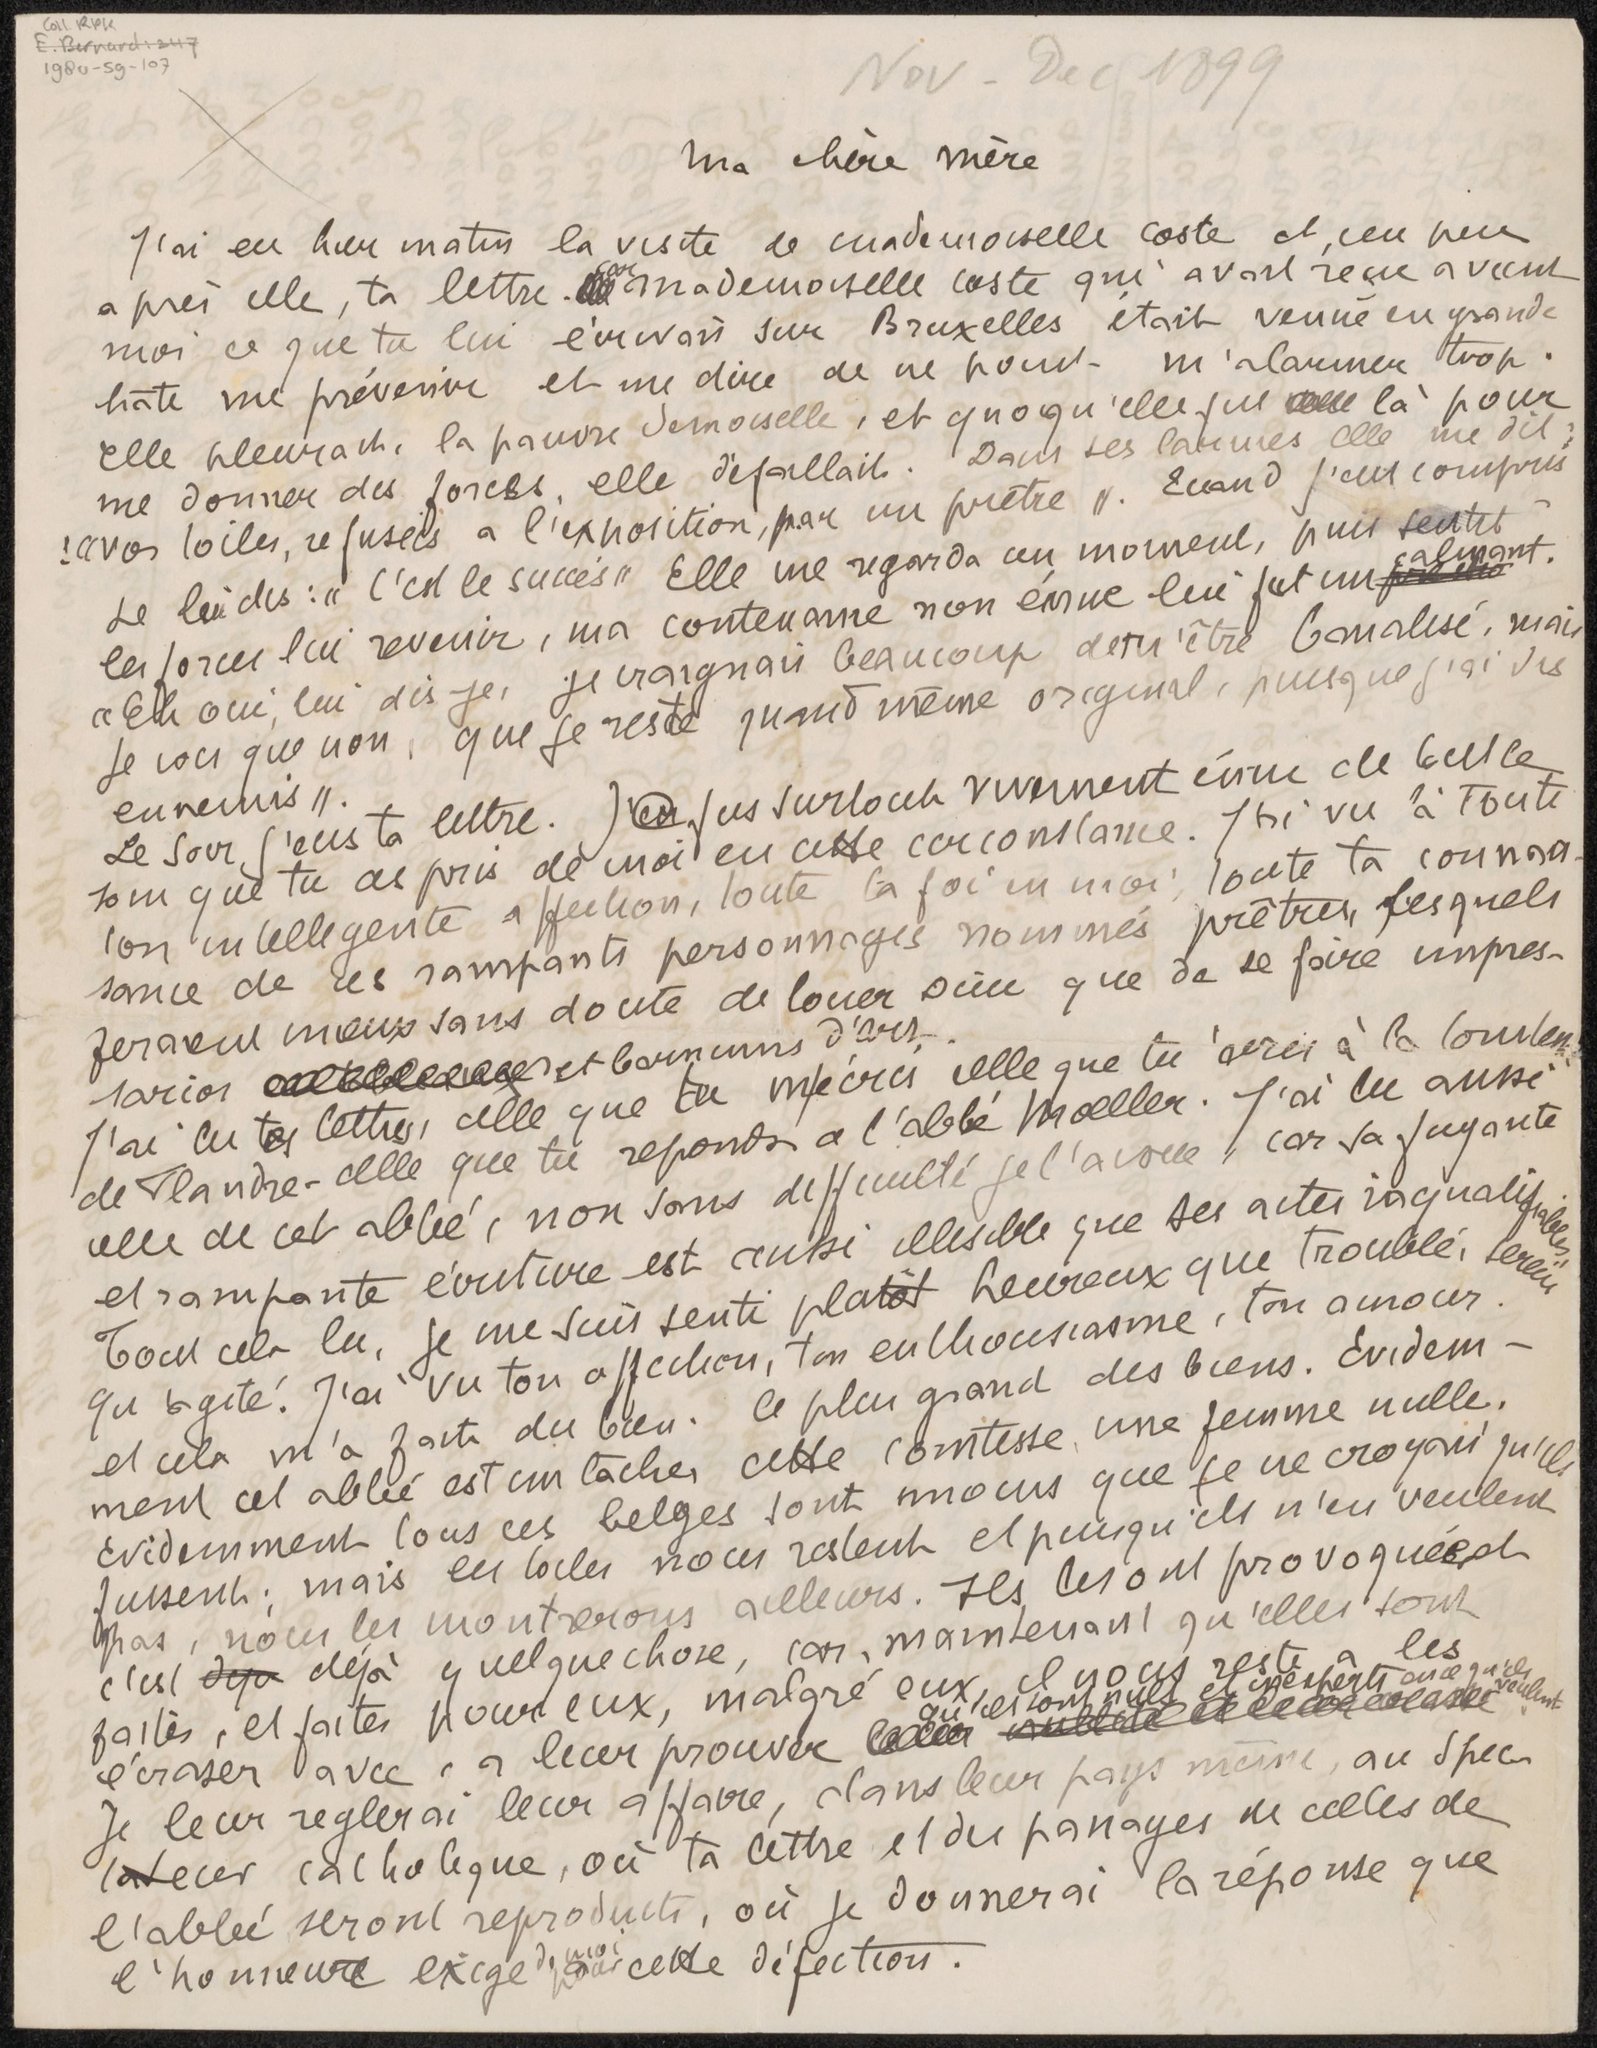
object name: letter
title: Brief aan Héloïse Bernard-Bodin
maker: émile bernard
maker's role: print maker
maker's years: 1868-1941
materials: ink, paper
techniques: pen, writing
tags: héloïse bernard-bodin